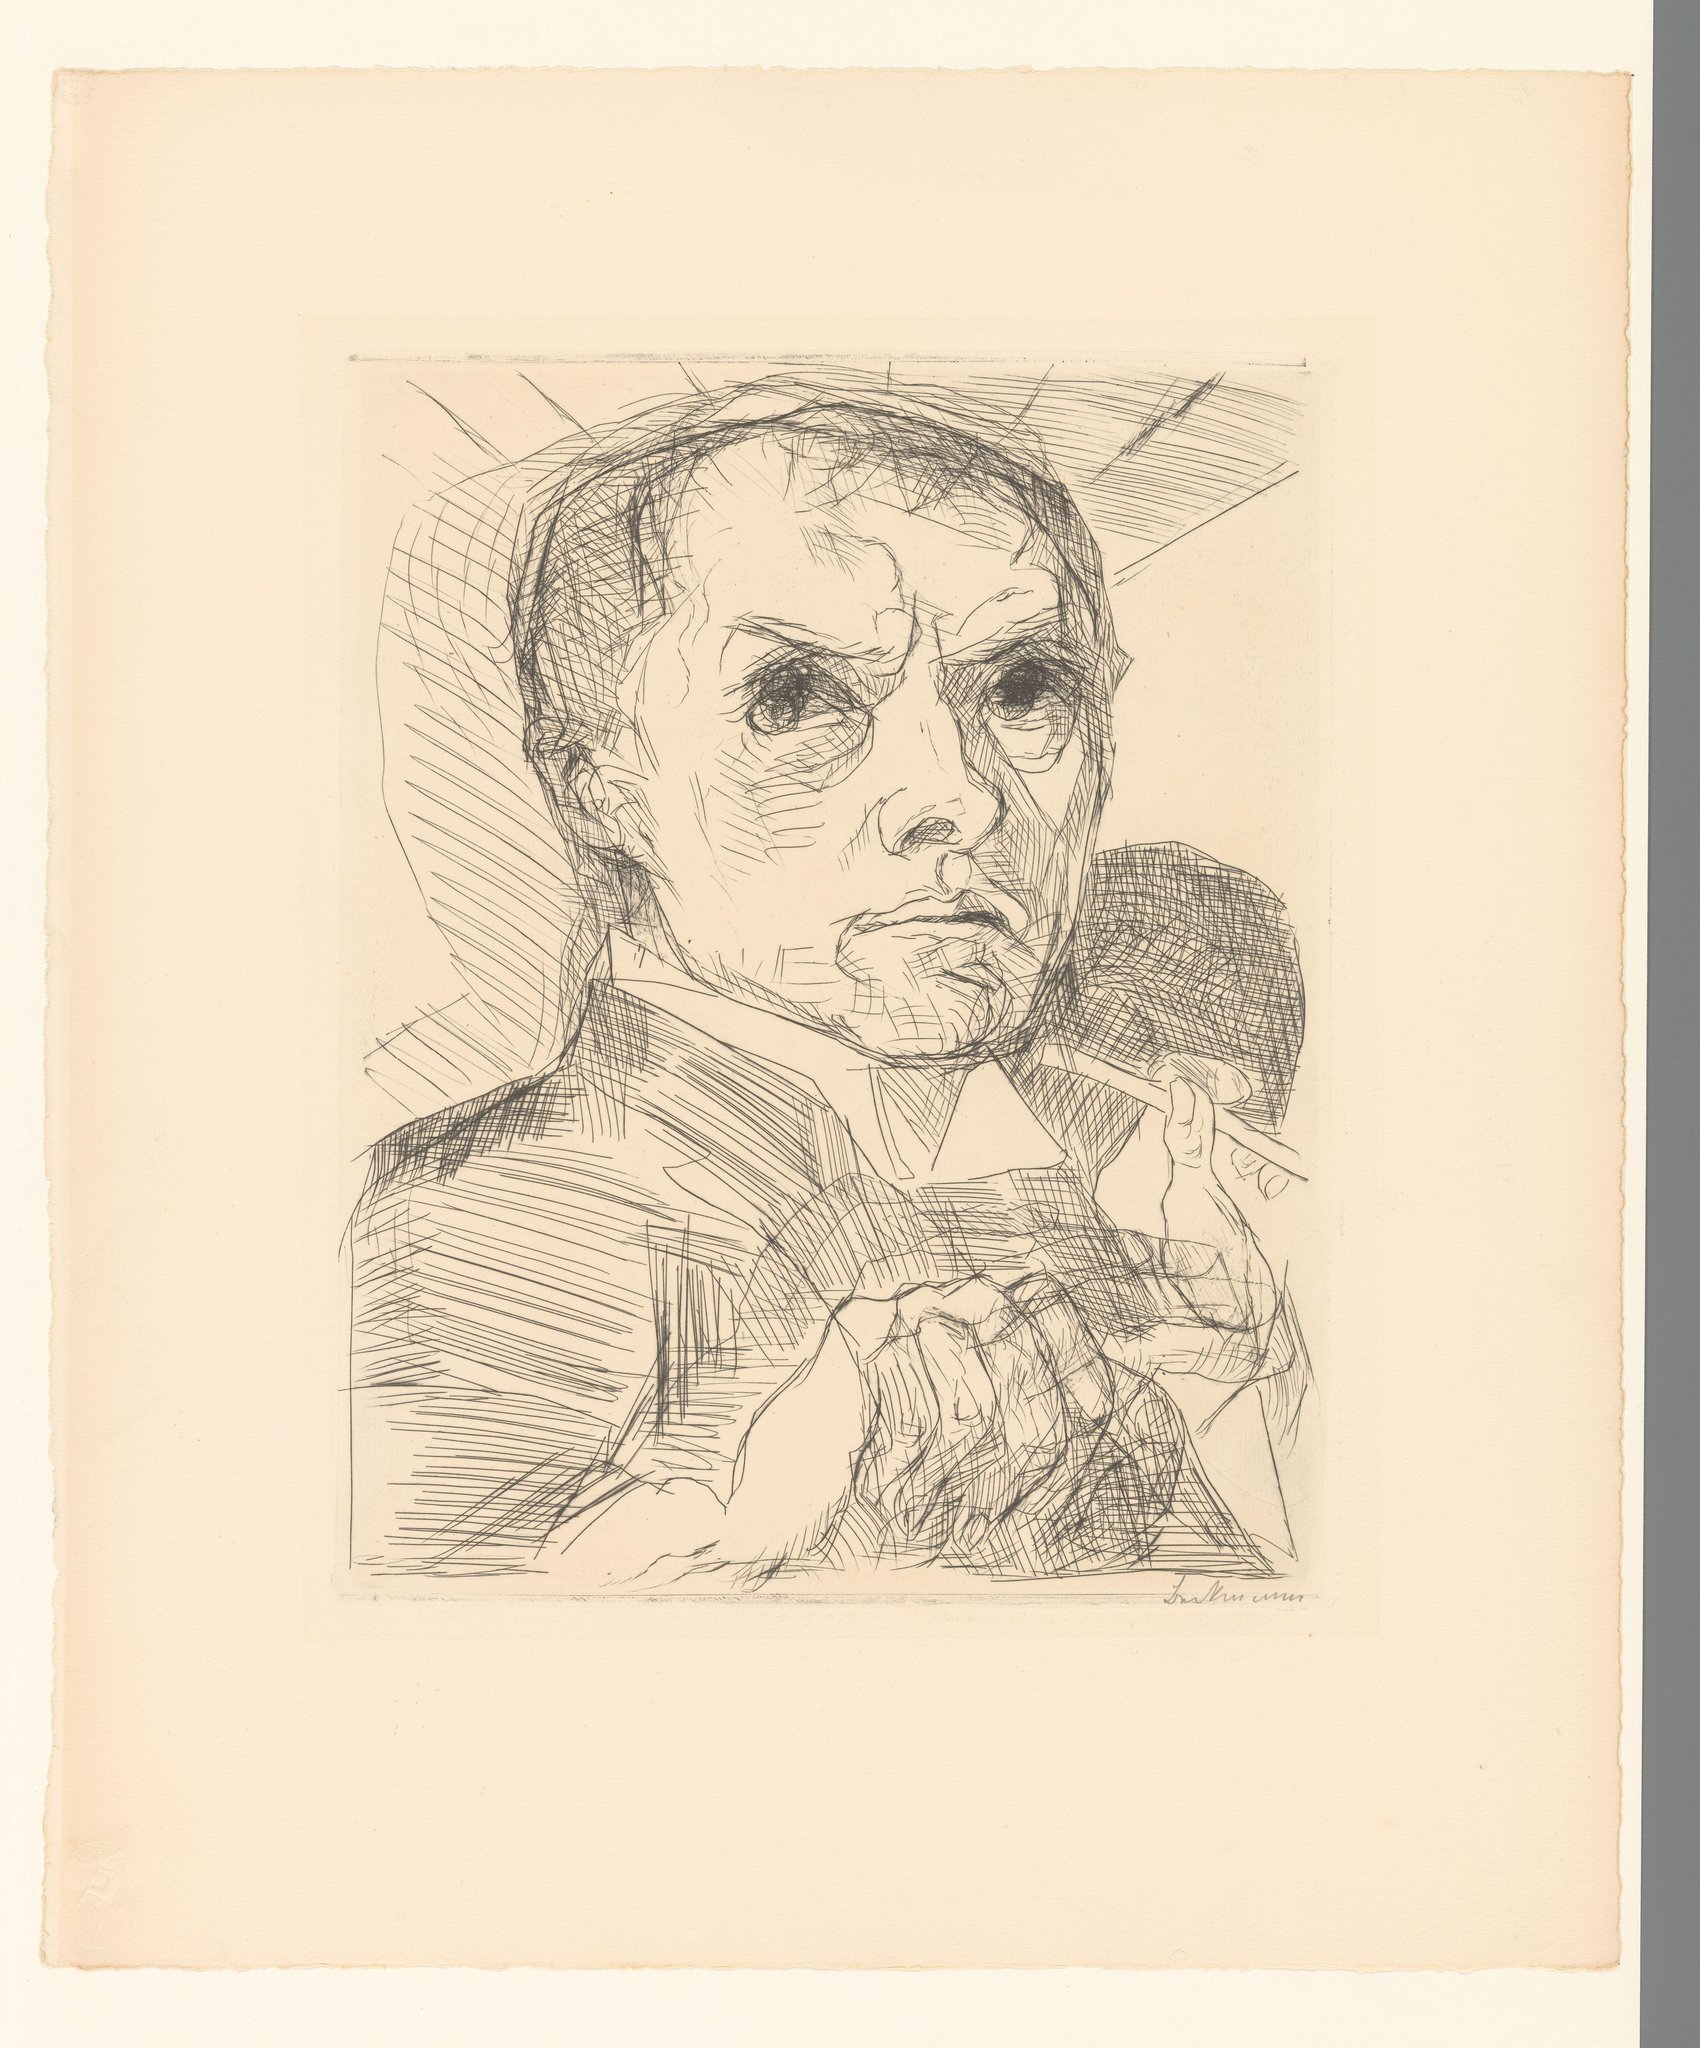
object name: print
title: Selbstbildnis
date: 1917-1919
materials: paper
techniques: drypoint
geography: munich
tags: new york (city), print maker, max beckmann, portrait, self-portrait of graphic artist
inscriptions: collector's mark: Lugt 2166, collector's mark: Lugt 5629